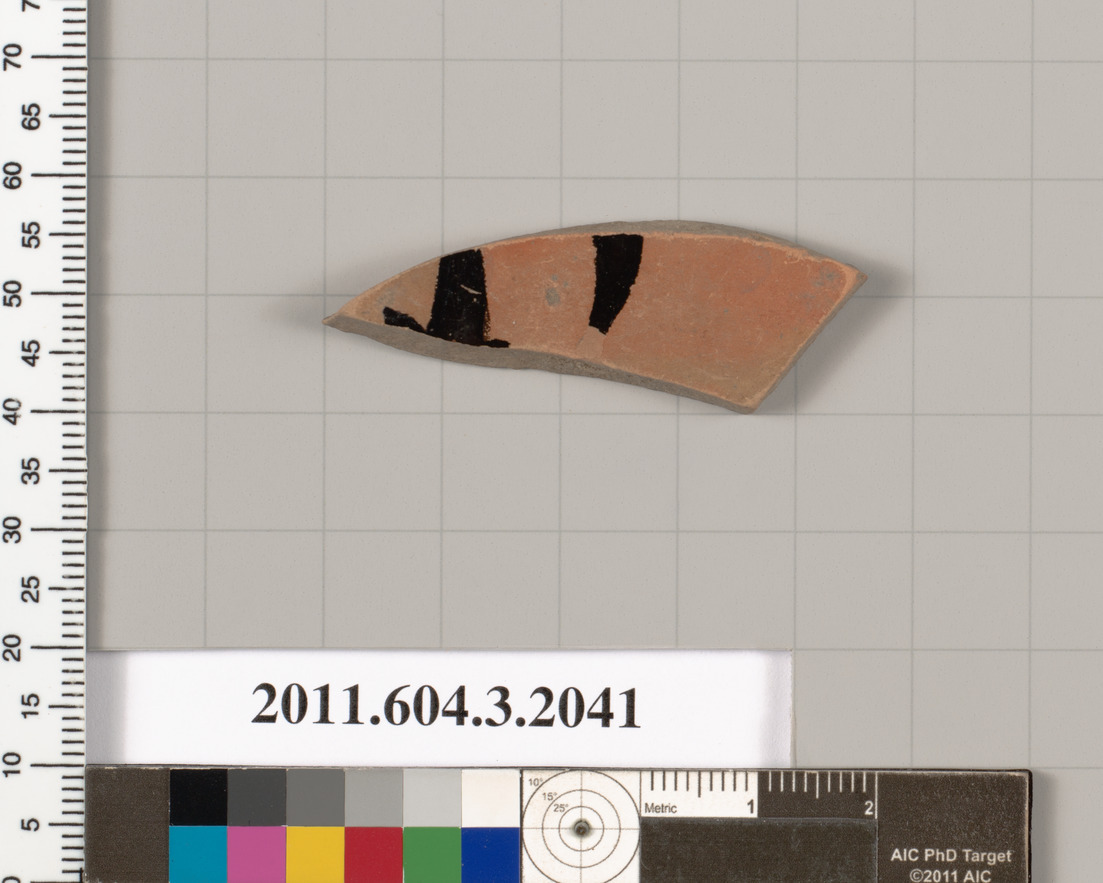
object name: kylix fragment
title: Terracotta fragment of a kylix (drinking cup)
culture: greek, attic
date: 500-468 BCE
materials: terracotta